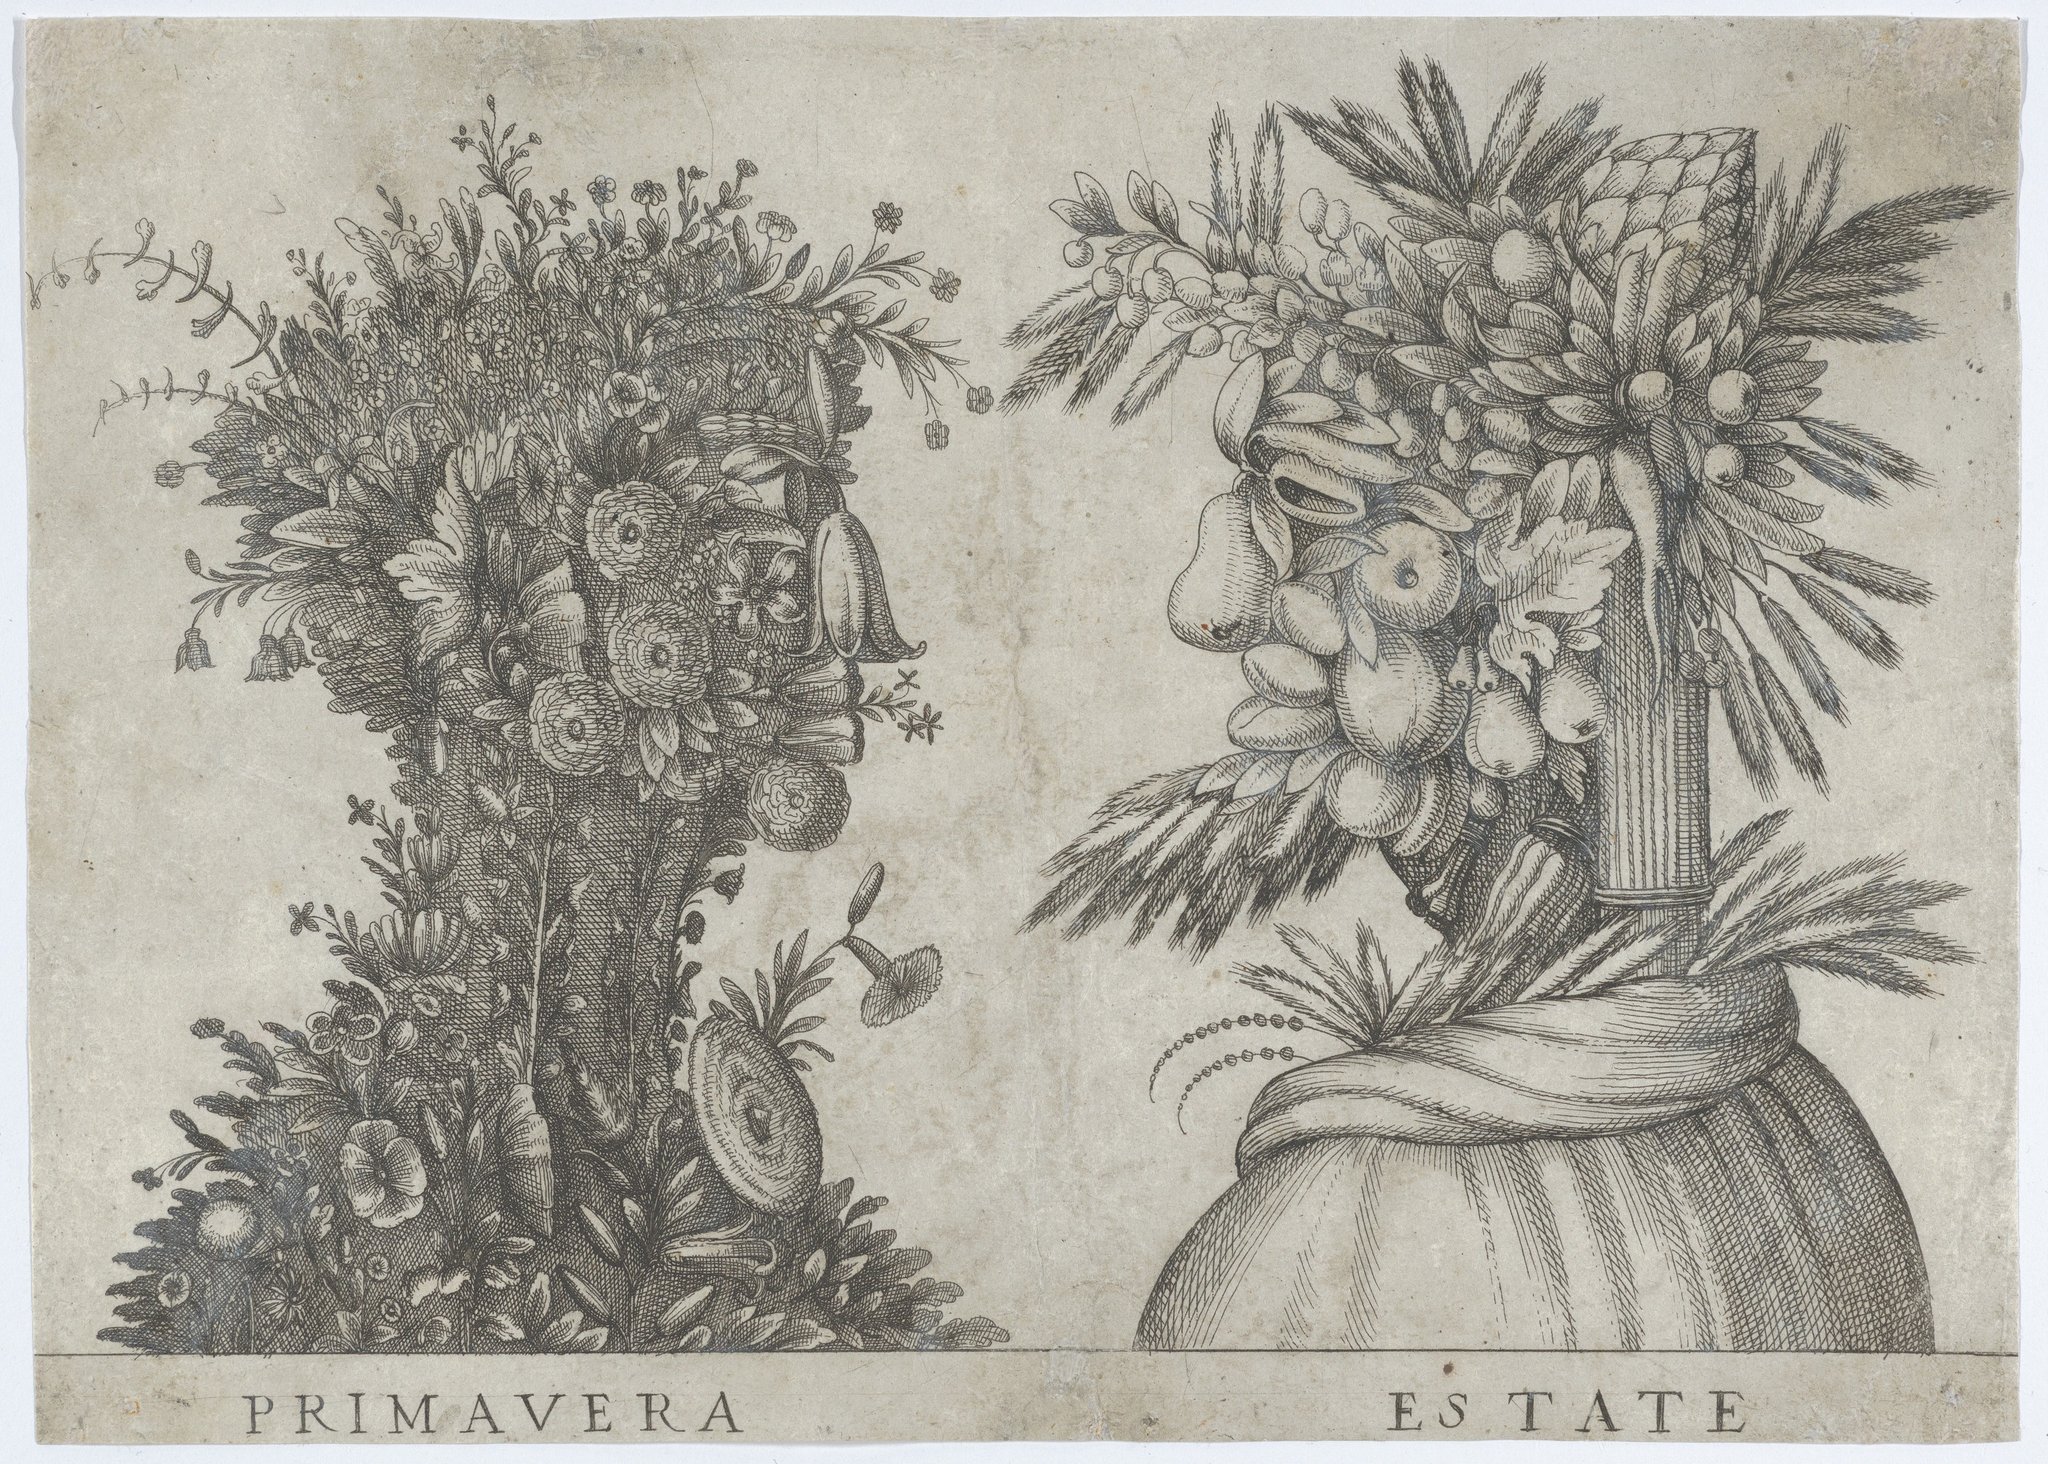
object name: print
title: Spring and Summer: two heads made from flora typical of those seasons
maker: anonymous, italian, 16th to early 17th century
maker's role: artist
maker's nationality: italian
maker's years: 1500-1640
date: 1580-1620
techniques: etching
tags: fruit,flowers